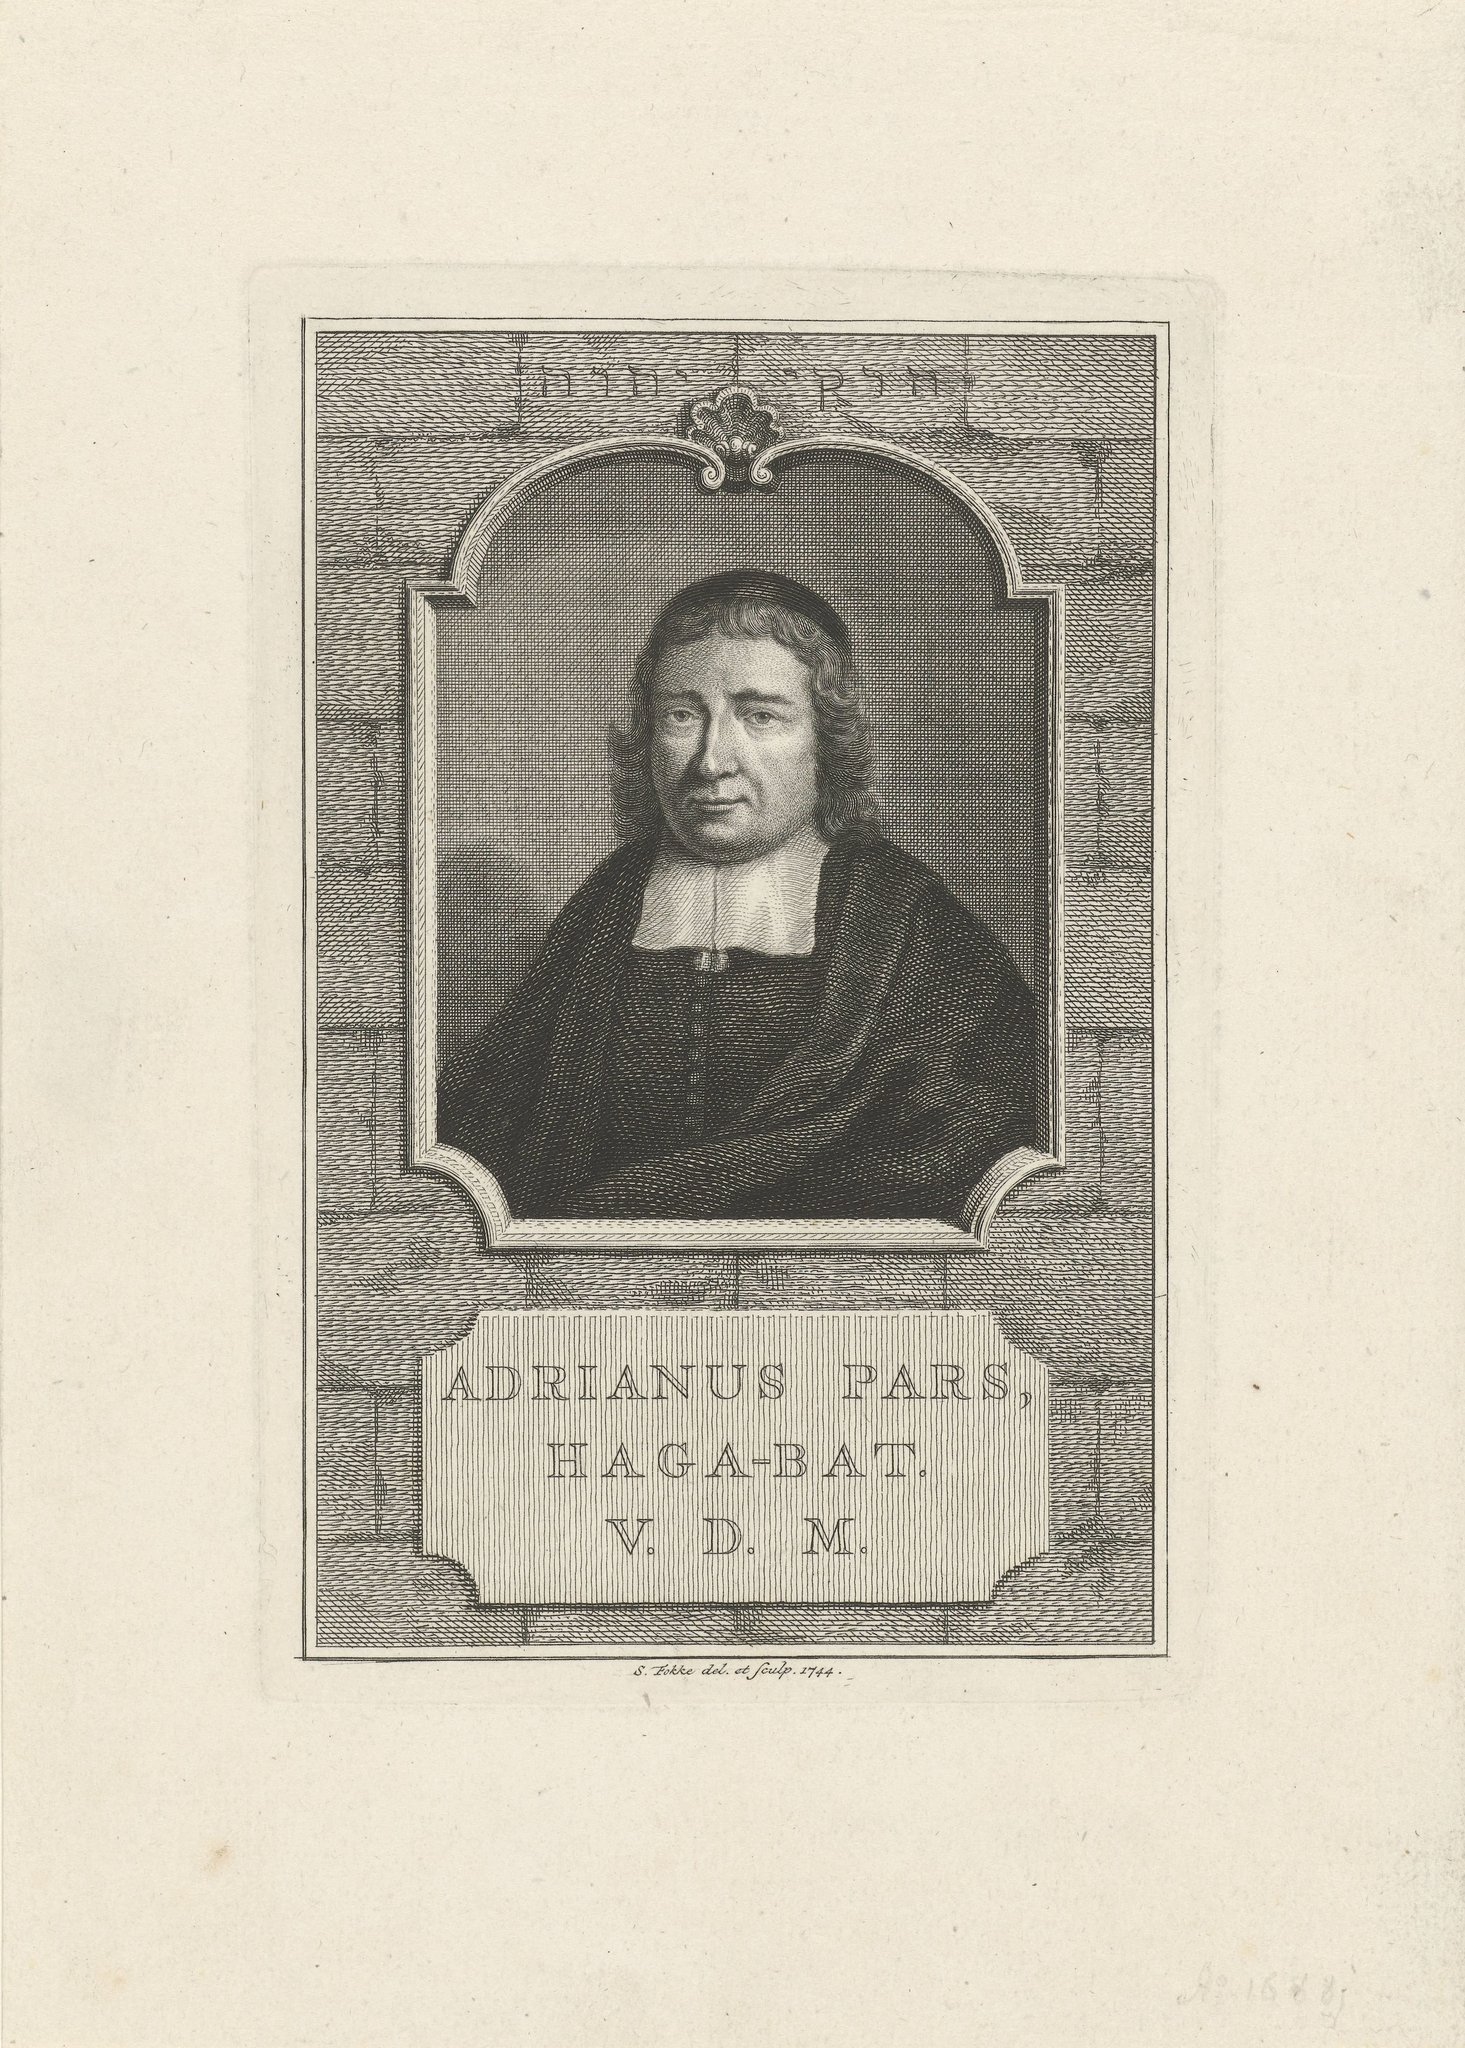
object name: print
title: Portret van Adriaan Pars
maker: simon fokke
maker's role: draughtsman, print maker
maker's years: 1712-1784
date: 1744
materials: paper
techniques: engraving, etching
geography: amsterdam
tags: the hague, historical person (with name)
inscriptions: collector's mark: Lugt 2228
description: Portretbuste van predikant Adrianus Pars met mantel en bef.